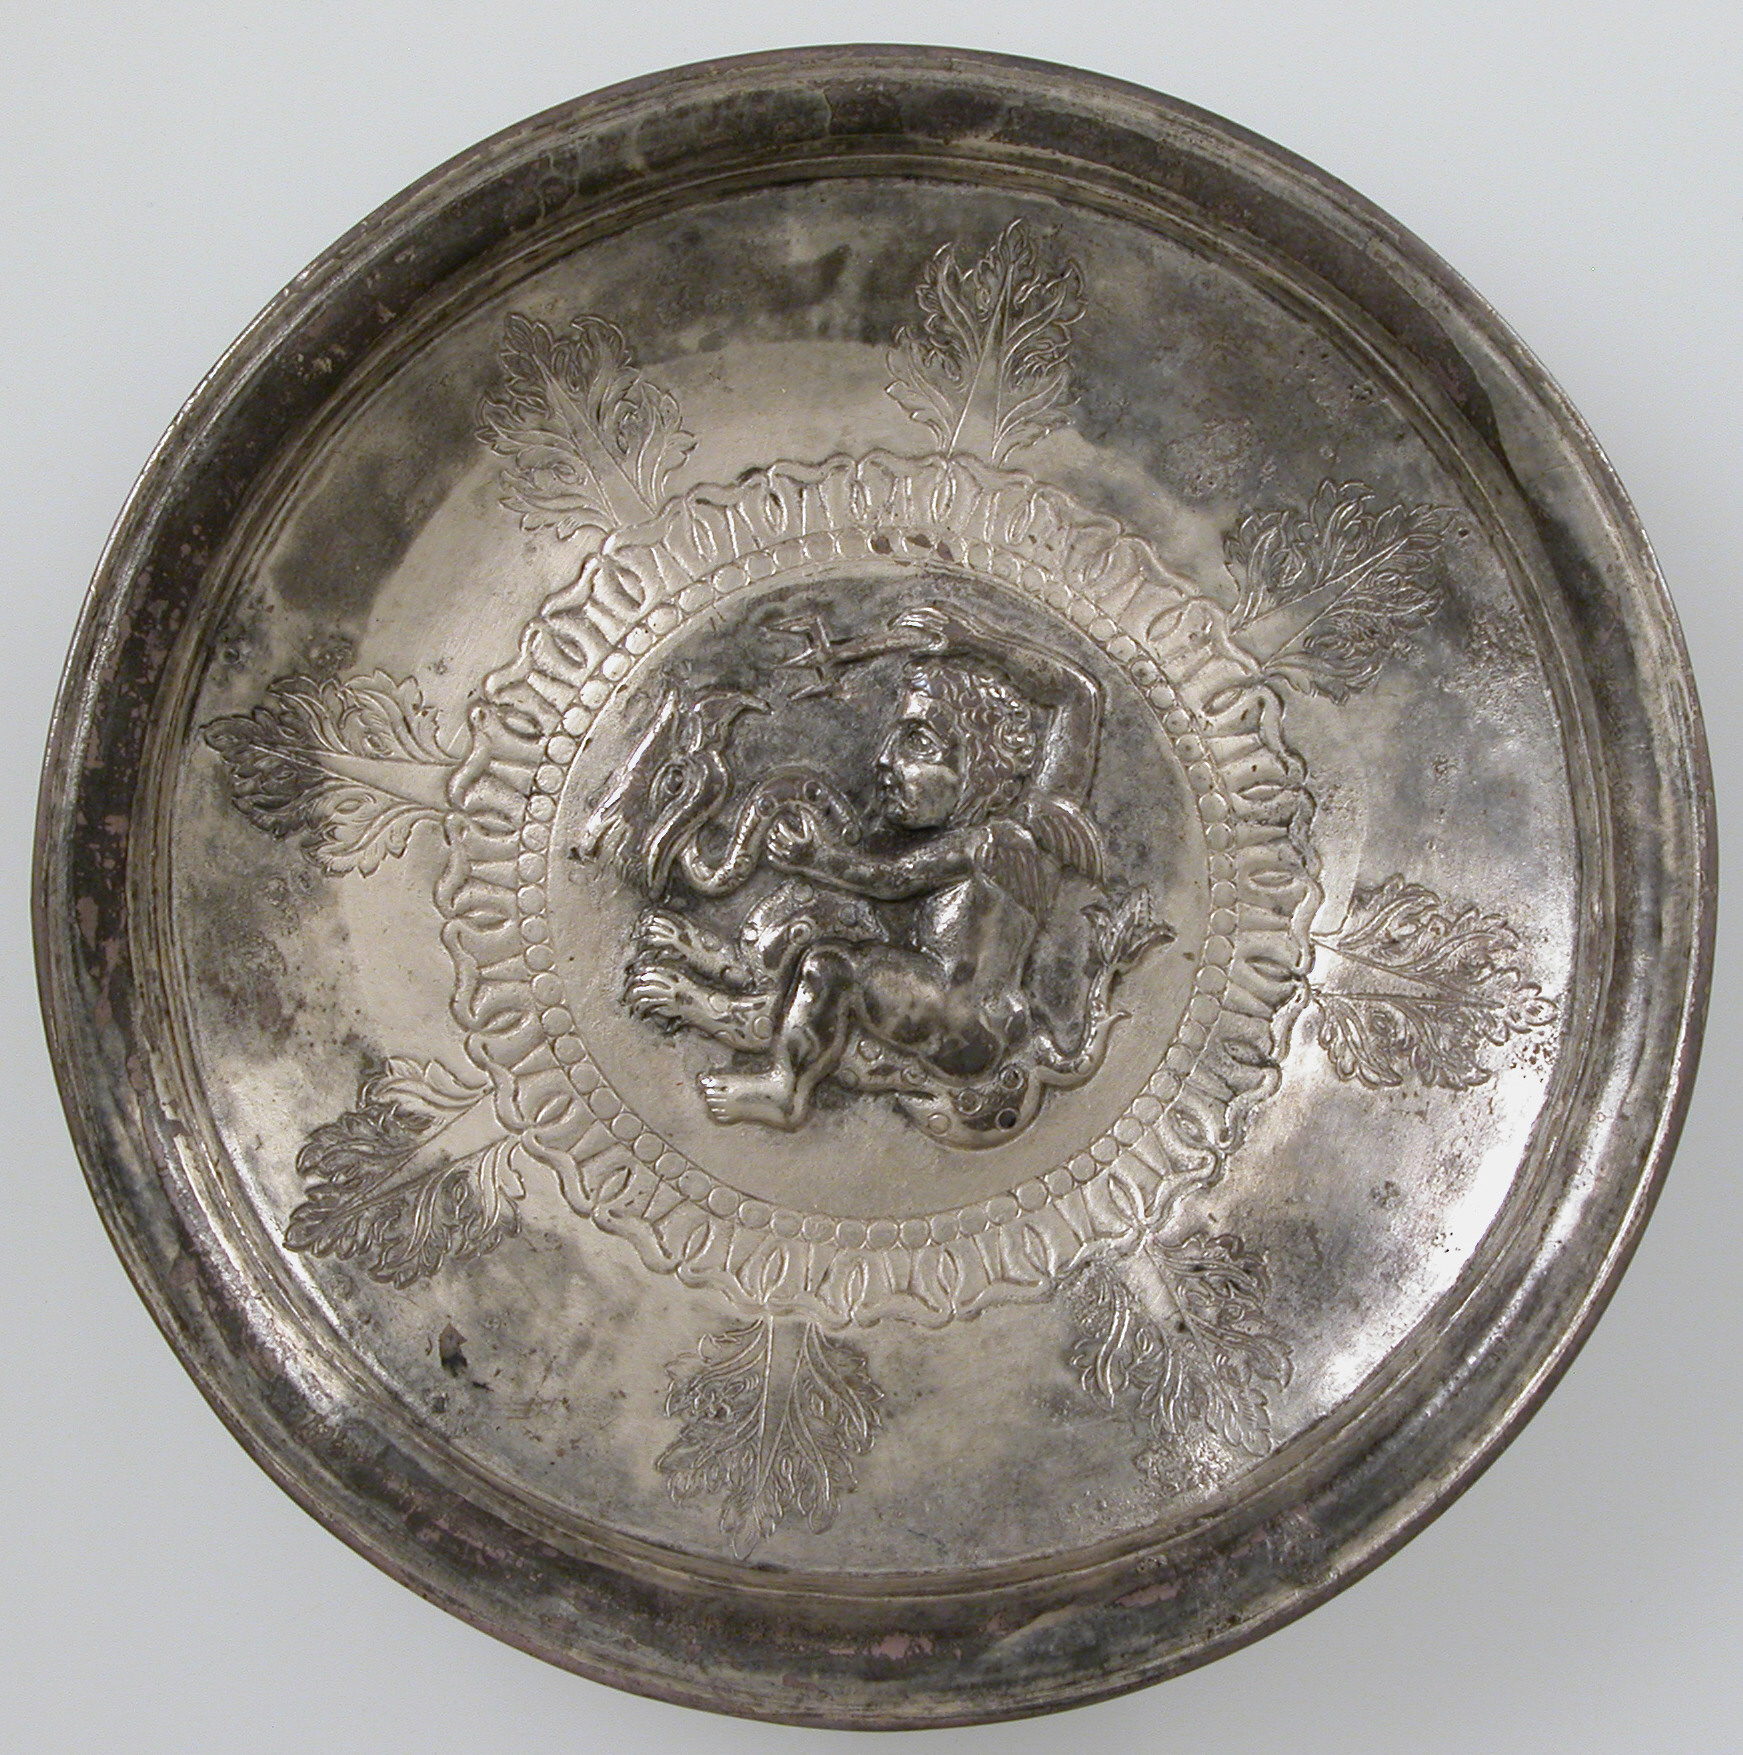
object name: dish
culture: byzantine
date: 501-700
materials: silver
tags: eros,mythical creatures